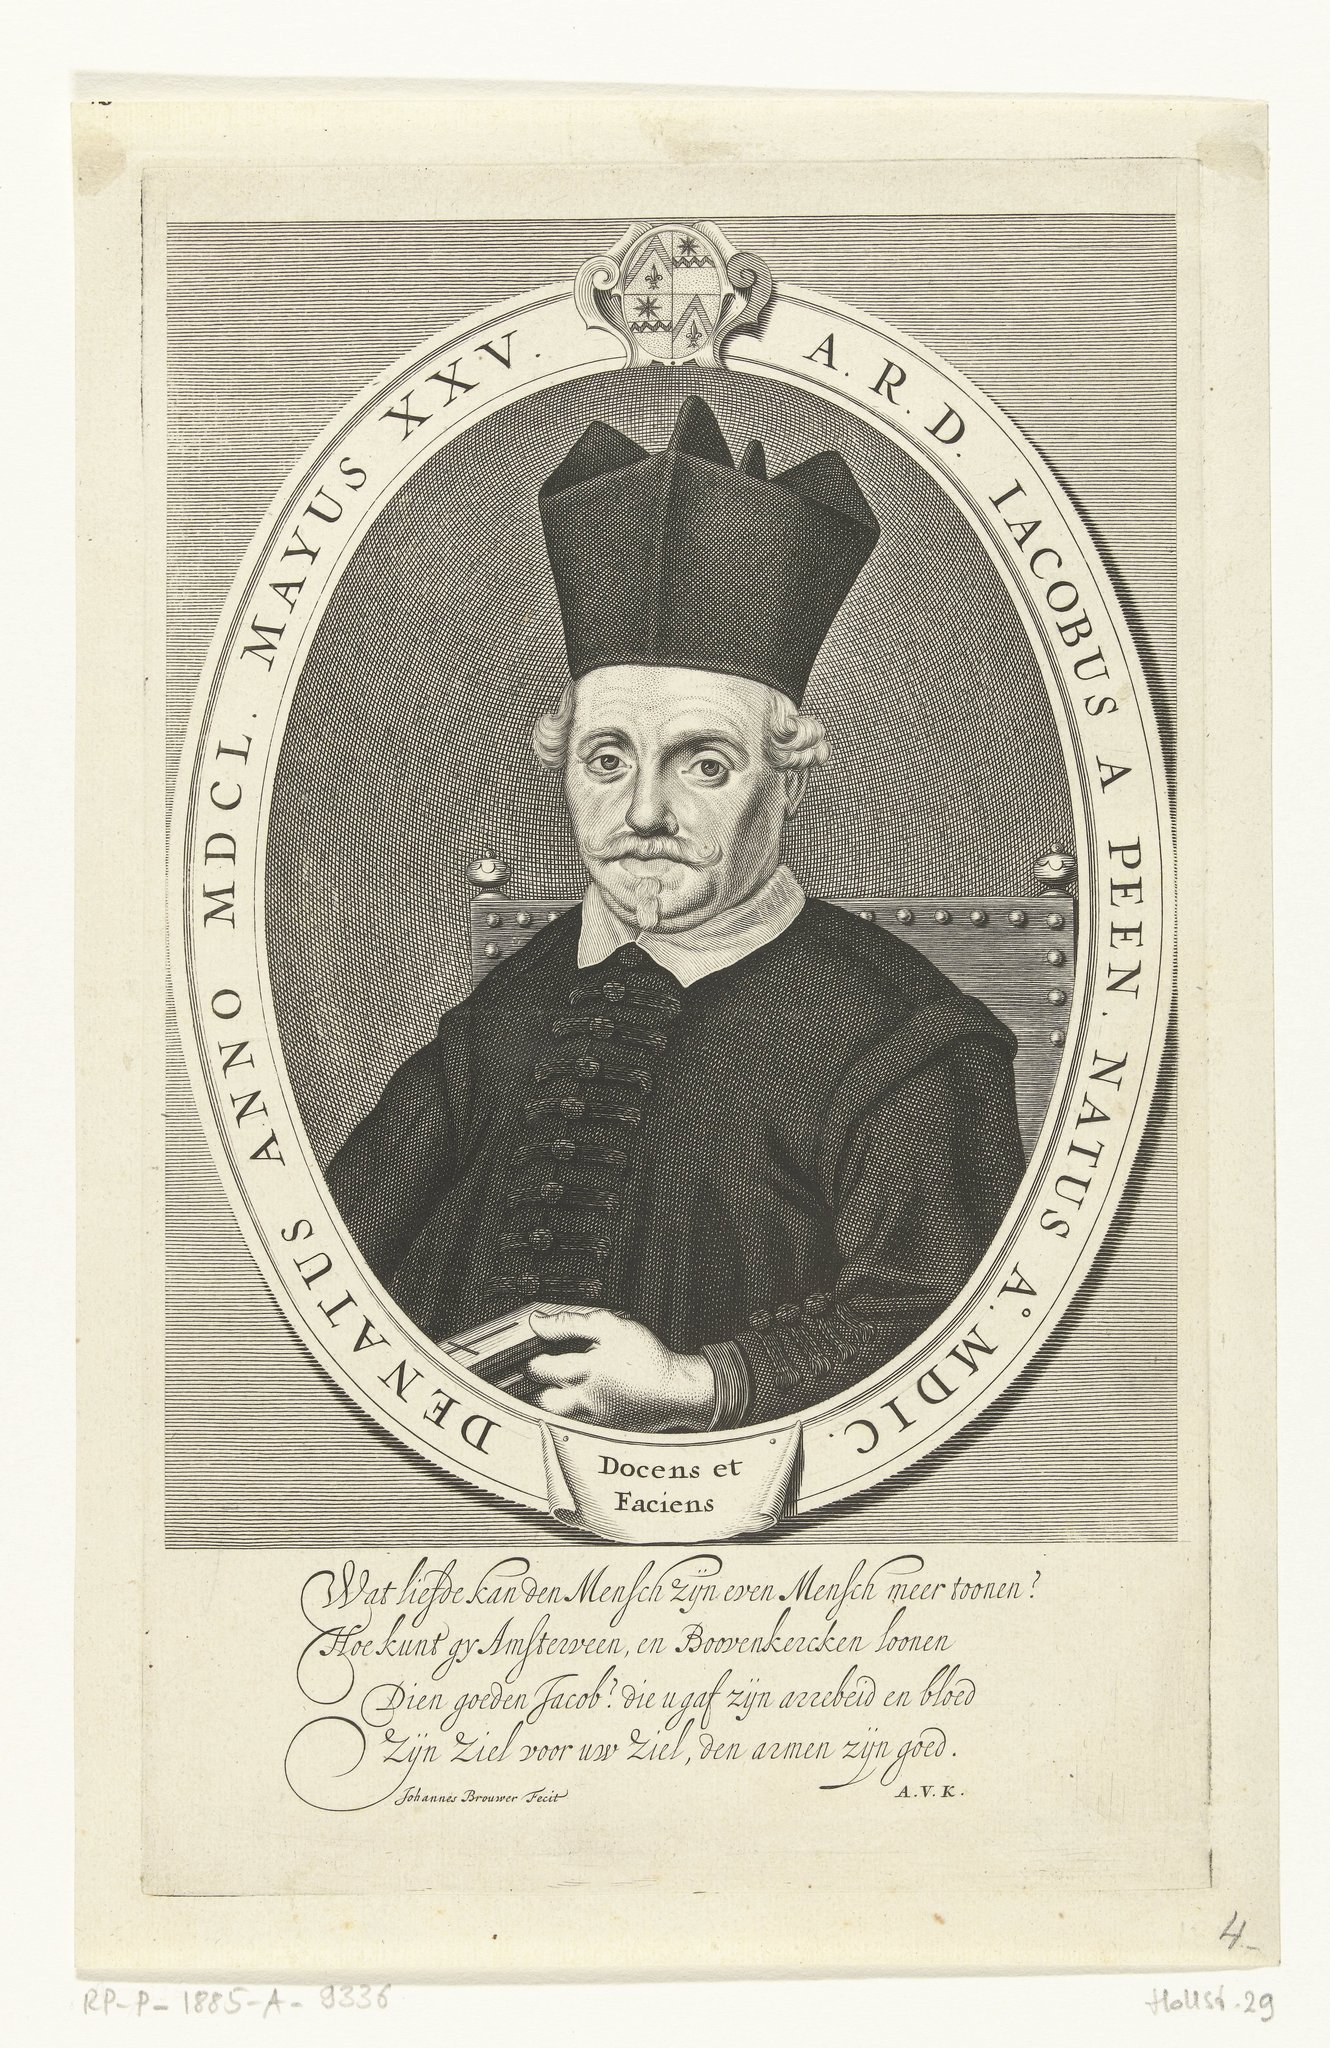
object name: print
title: Portret van Jacobus van Peen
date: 1650-1660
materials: paper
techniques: engraving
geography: amsterdam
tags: pastoor, jacobus van peen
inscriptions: collector's mark: Lugt 2228